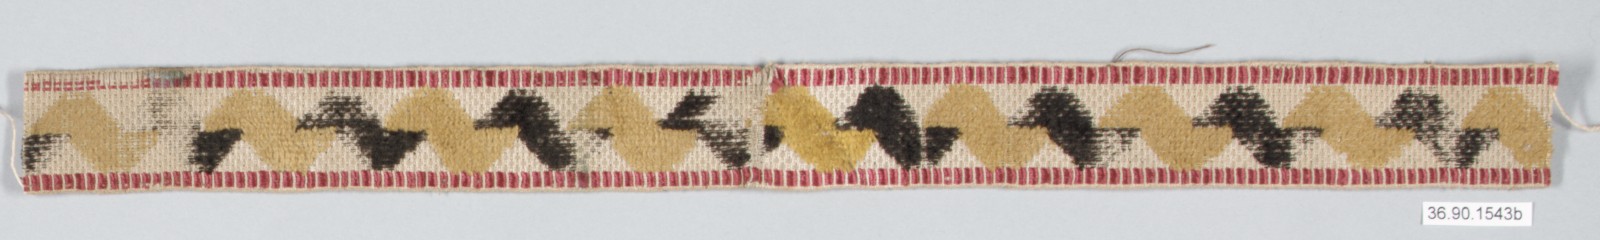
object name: galloon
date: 1701-1900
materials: silk